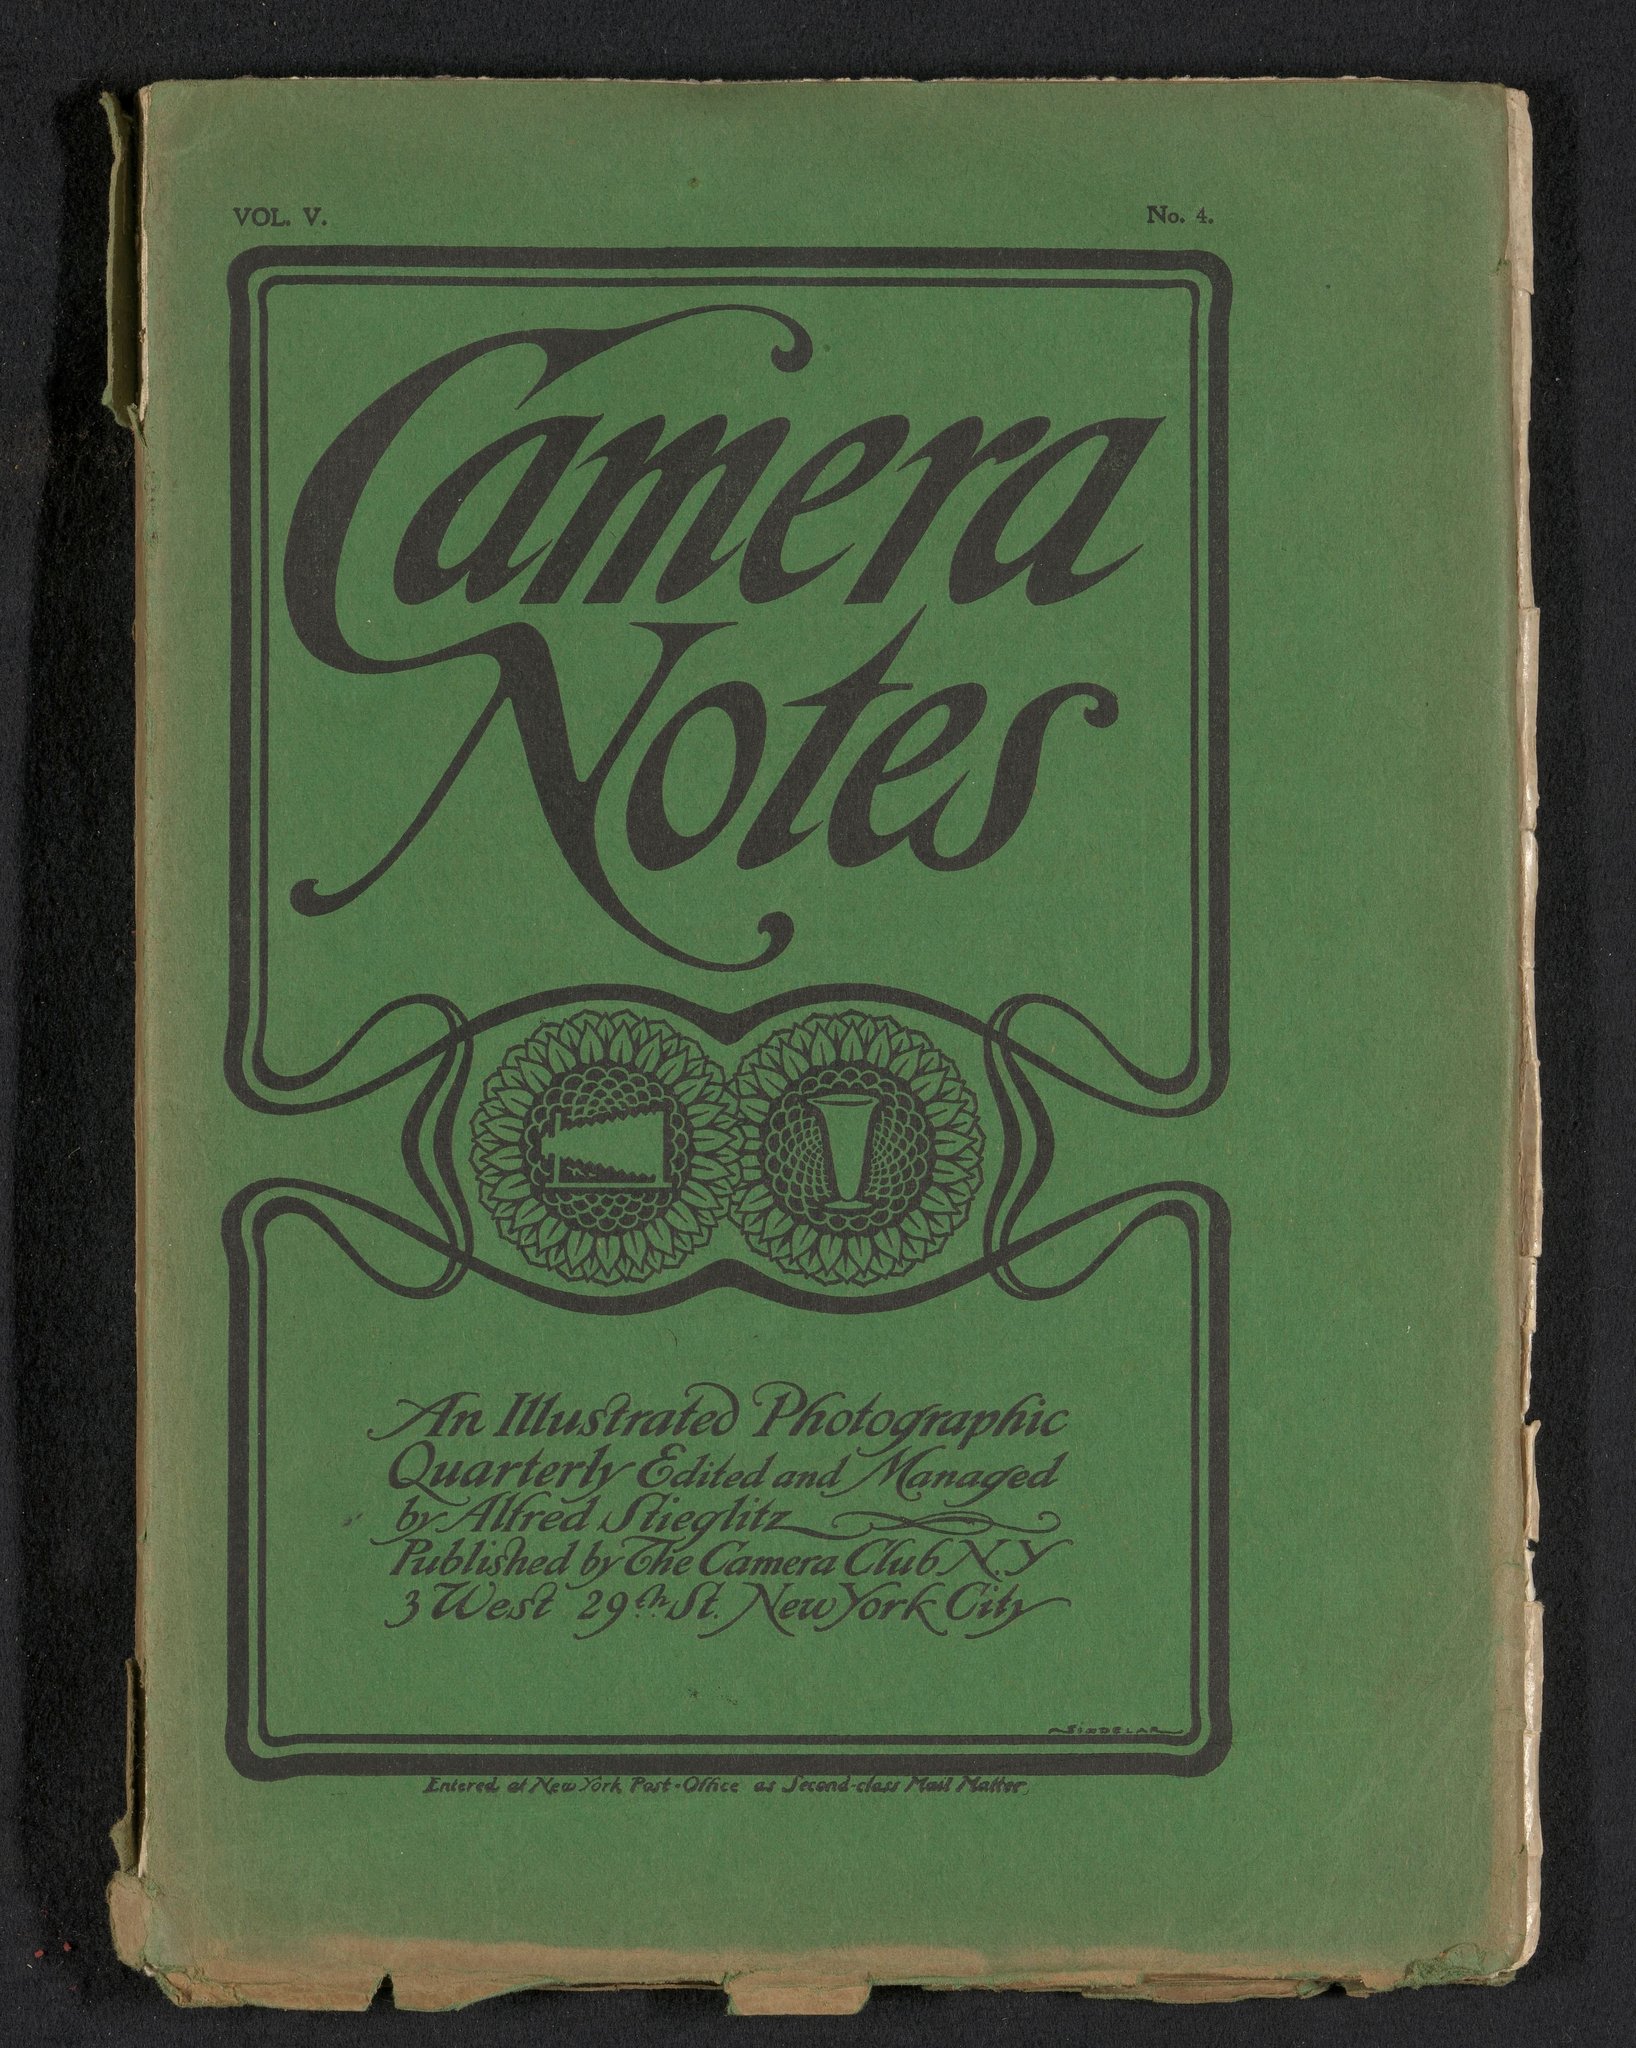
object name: book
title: Camera notes / The Camera Club of New York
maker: alfred stieglitz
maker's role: fotograaf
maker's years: 1864-1946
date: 1902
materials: cardboard, paper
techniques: photoaquatint, printing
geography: new york city